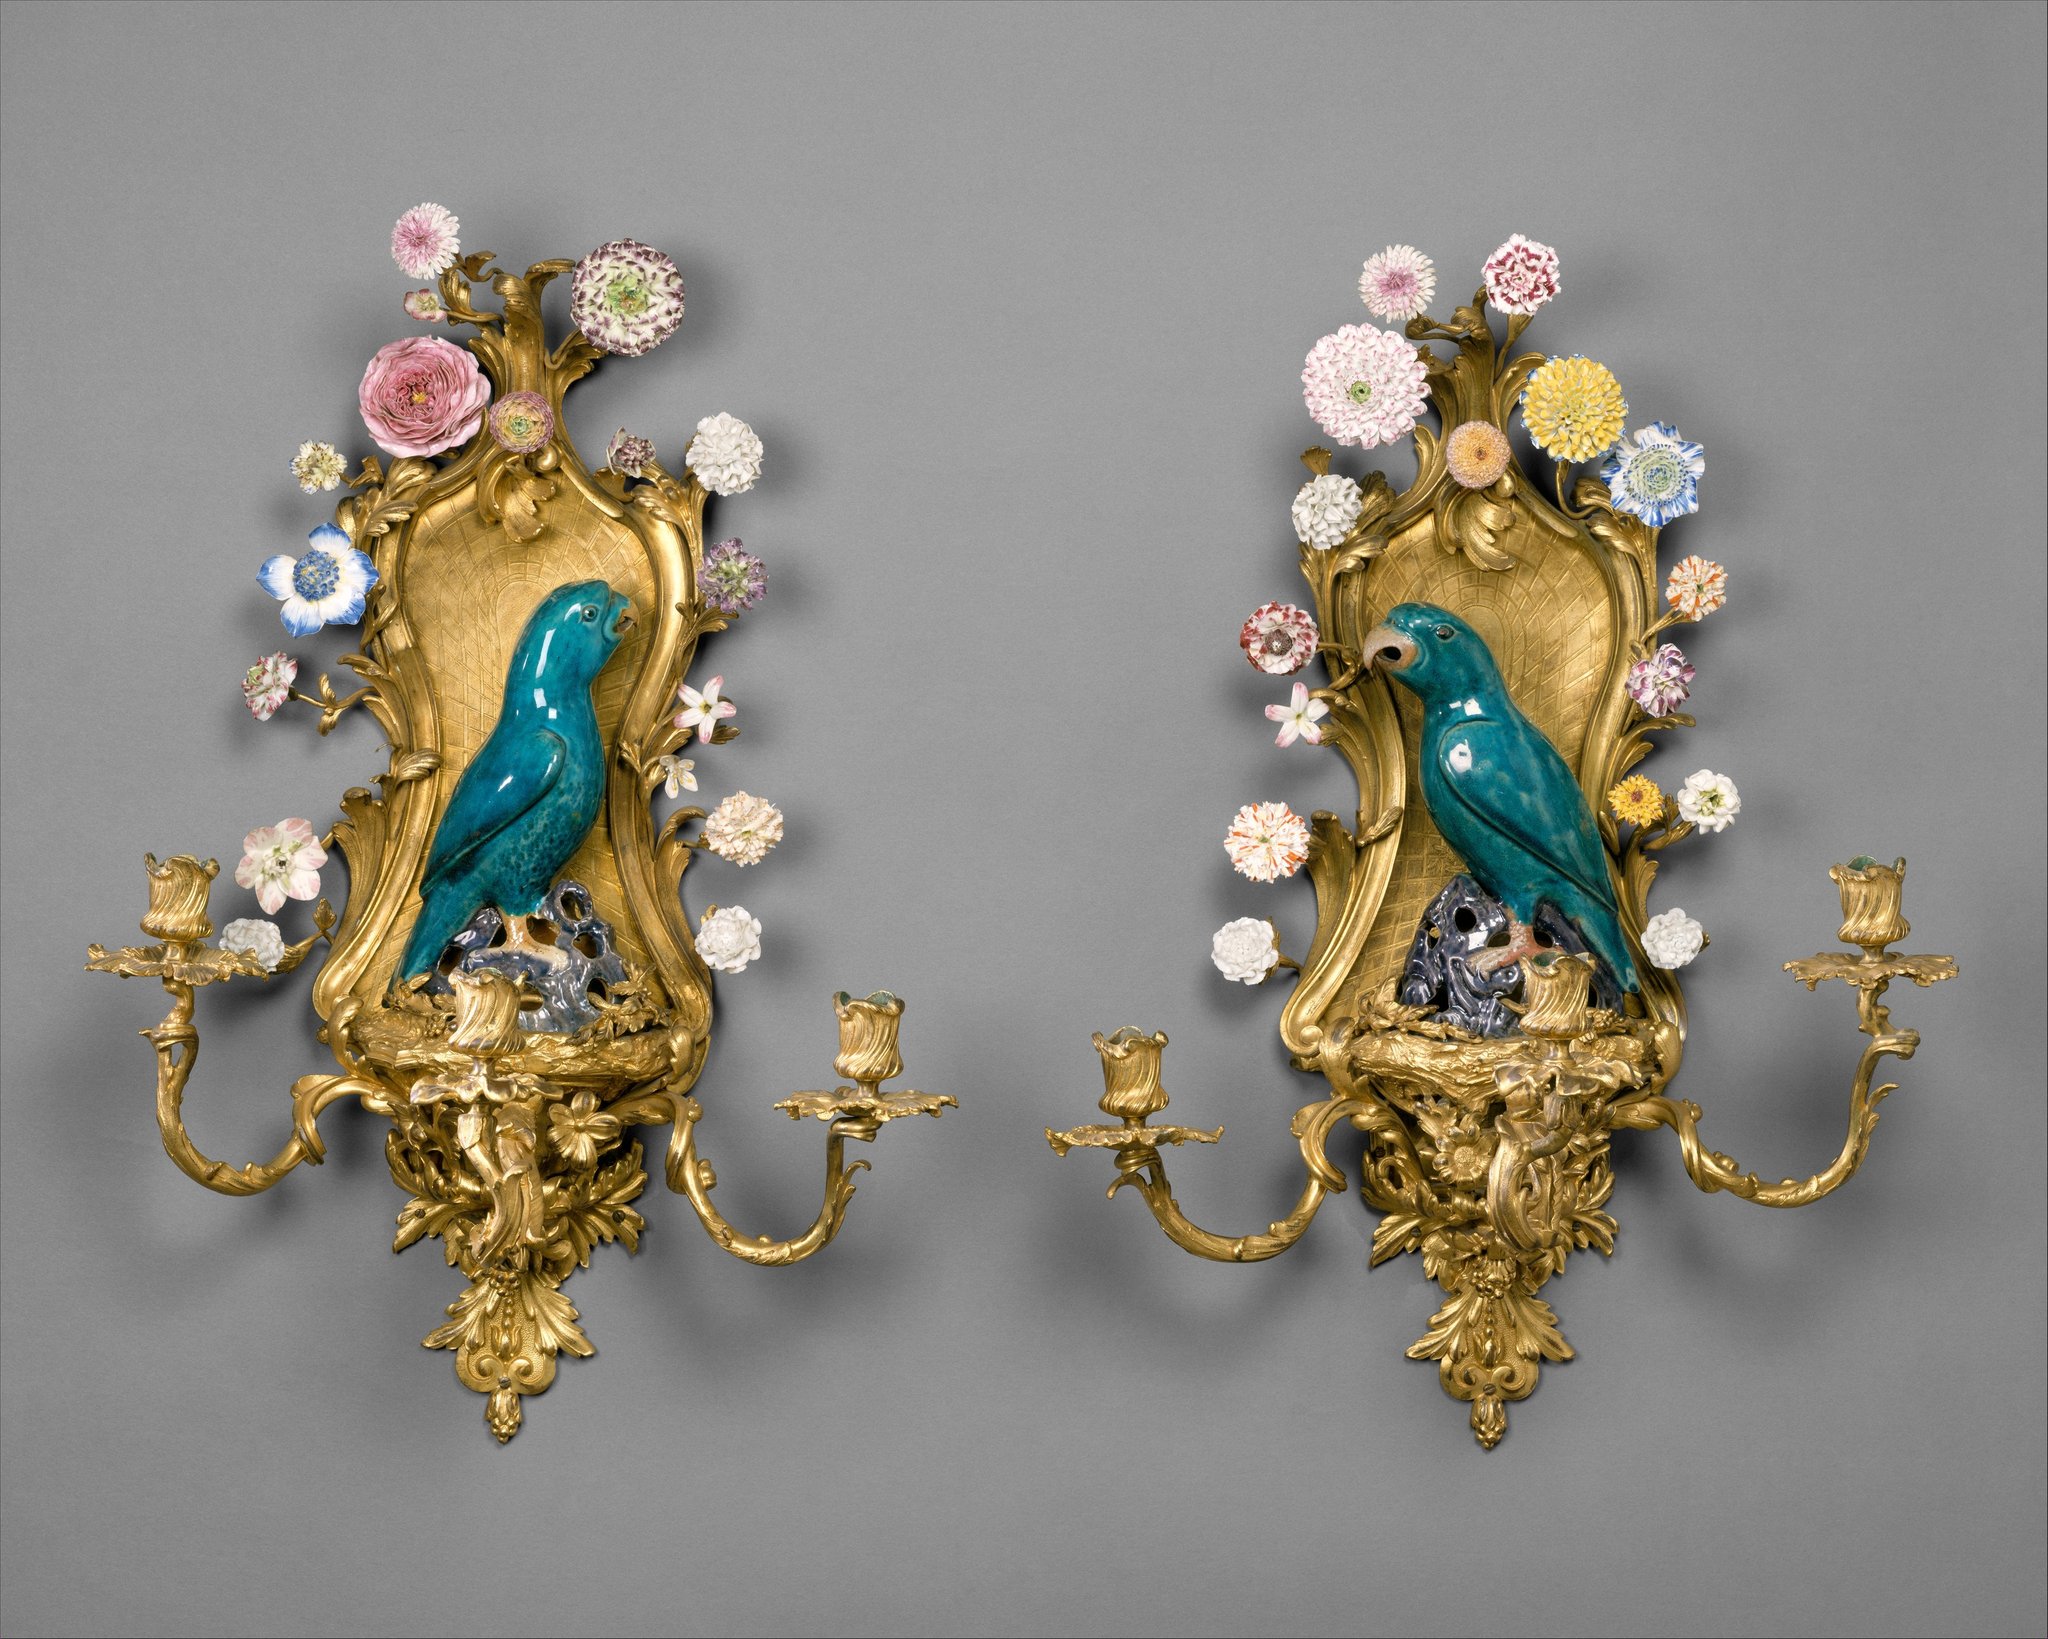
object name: wall light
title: Wall light (one of a pair)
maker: vincennes manufactory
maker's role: manufactory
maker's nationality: french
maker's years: 1740-1756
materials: biscuit, gilt bronze, paste, porcelain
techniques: glazing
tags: parrots,flowers